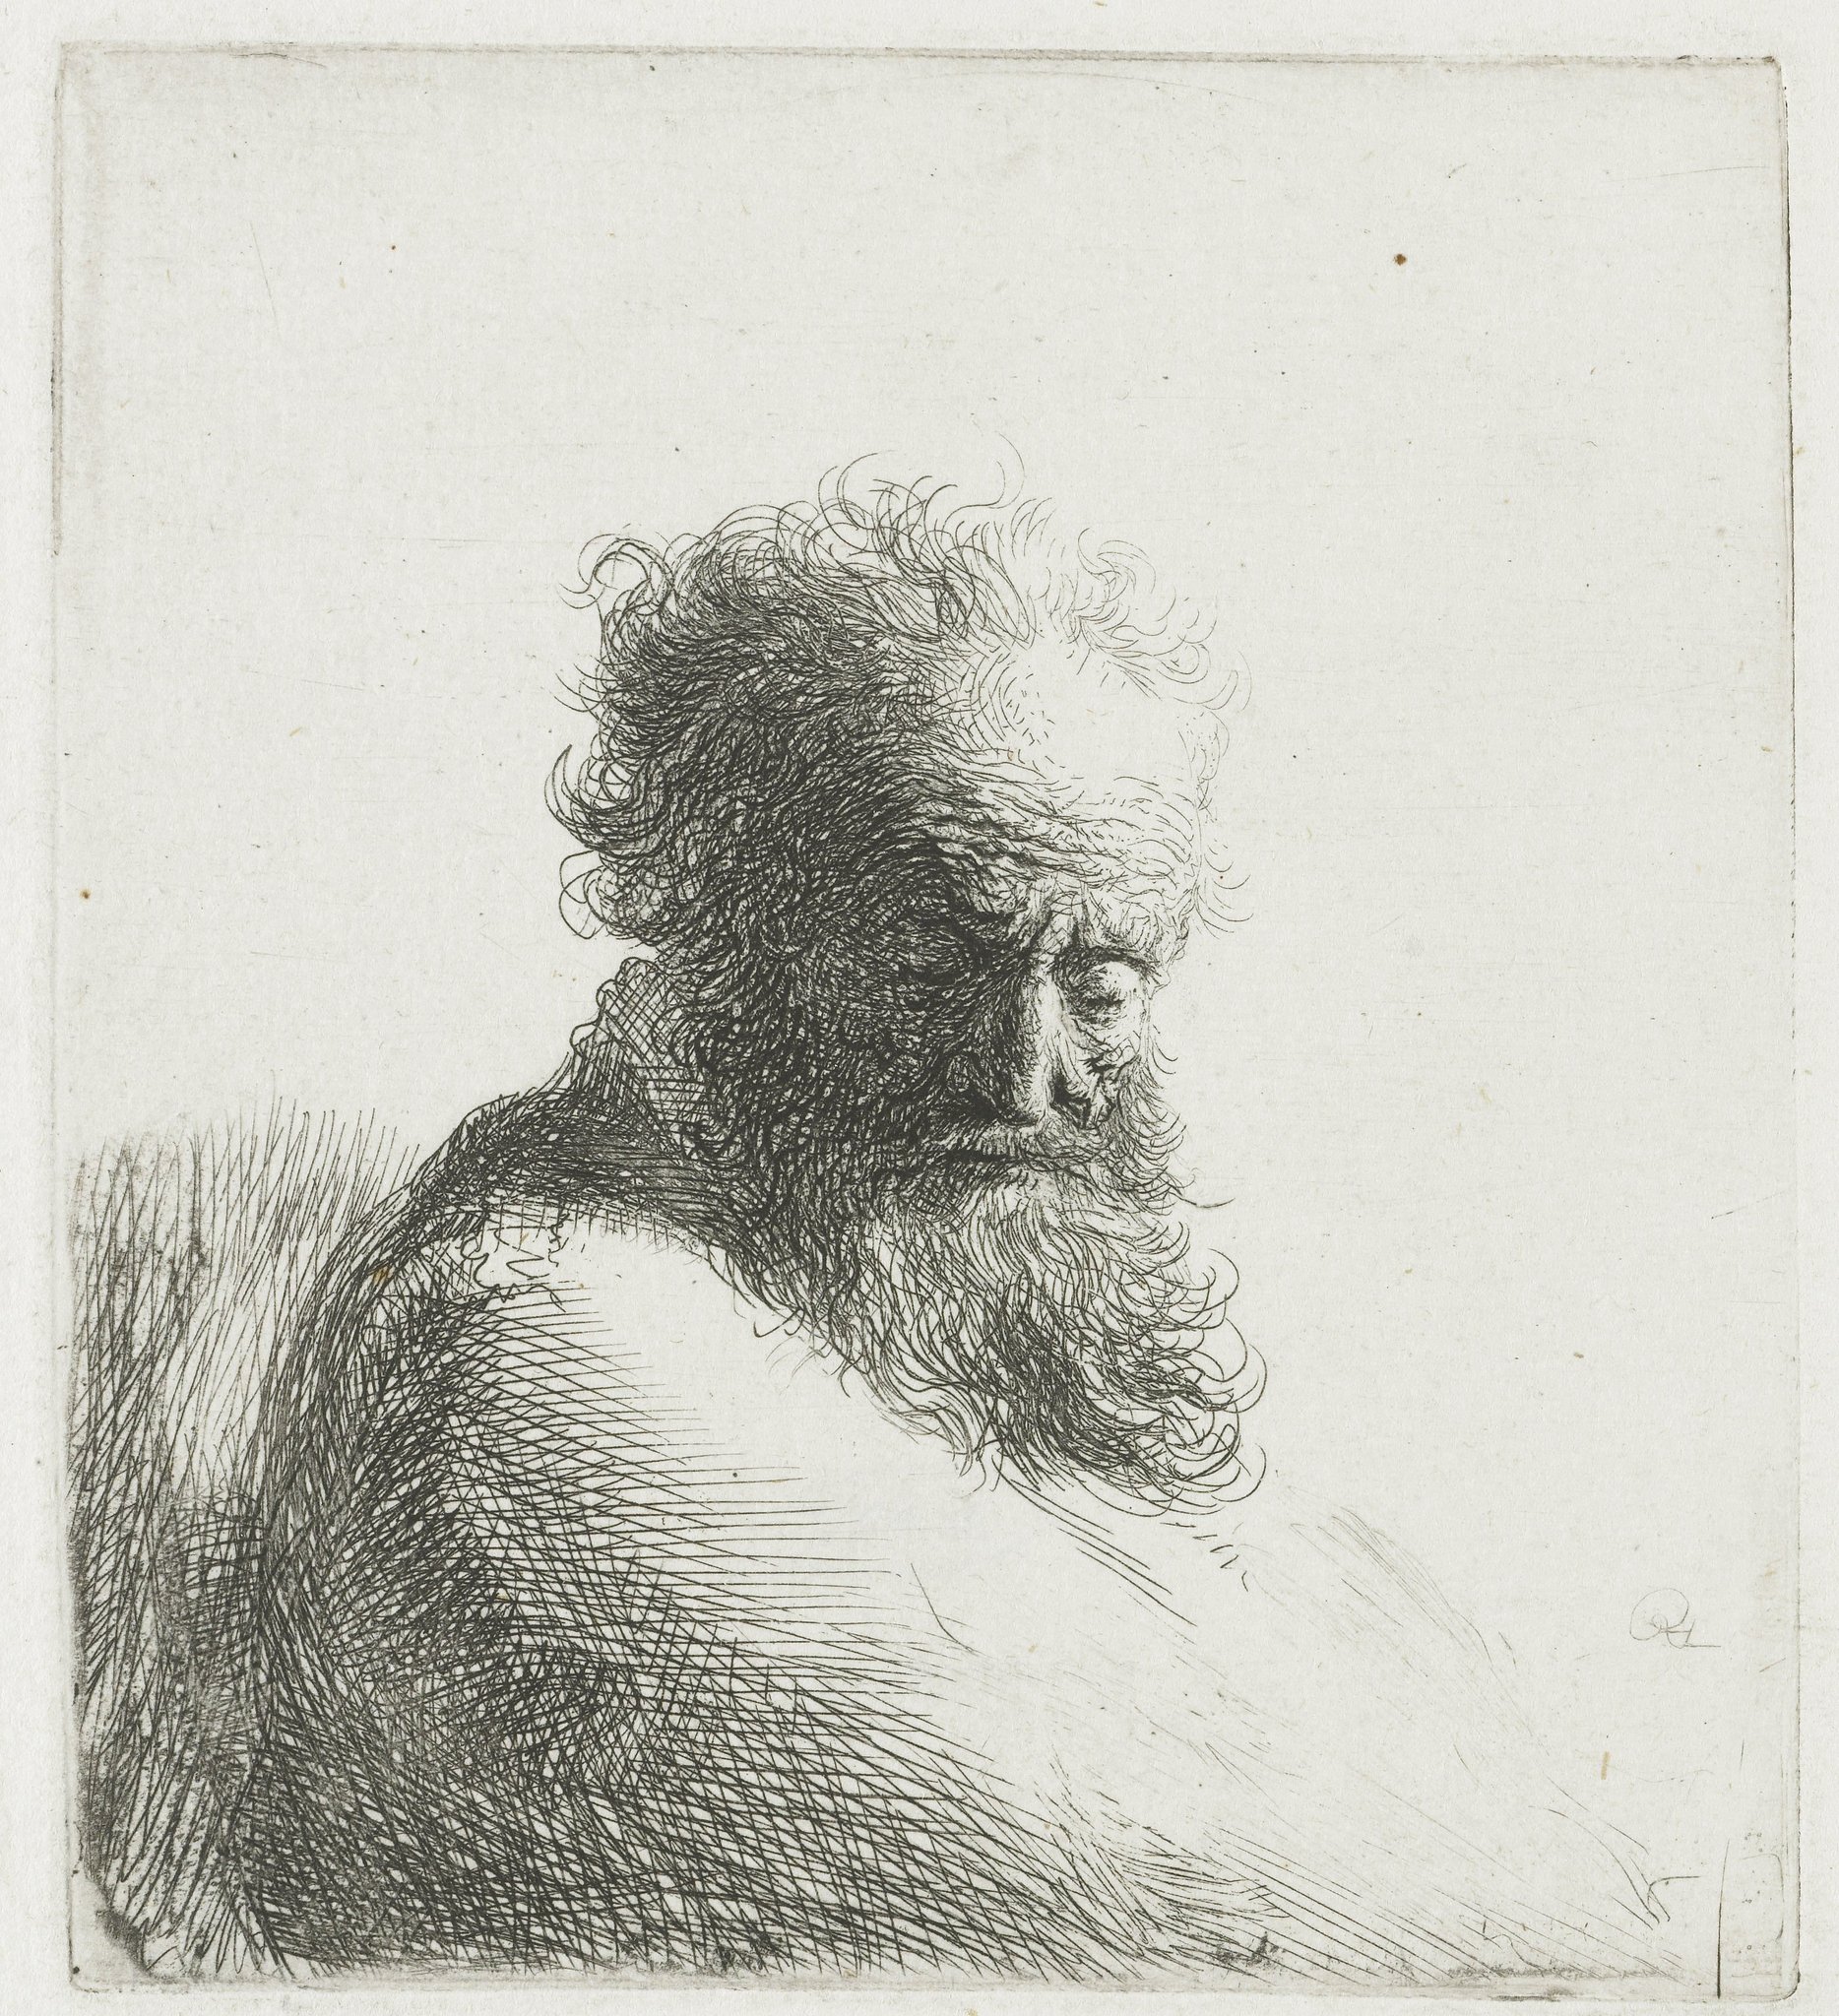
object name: print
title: Bust of an old bearded man, looking down, three quarters right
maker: rembrandt van rijn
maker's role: draughtsman, painter, print maker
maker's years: 1606-1669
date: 1631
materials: paper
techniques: etching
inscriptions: monogram and date: ‘RHL 16 (laatste twee getallen weggevallen)’